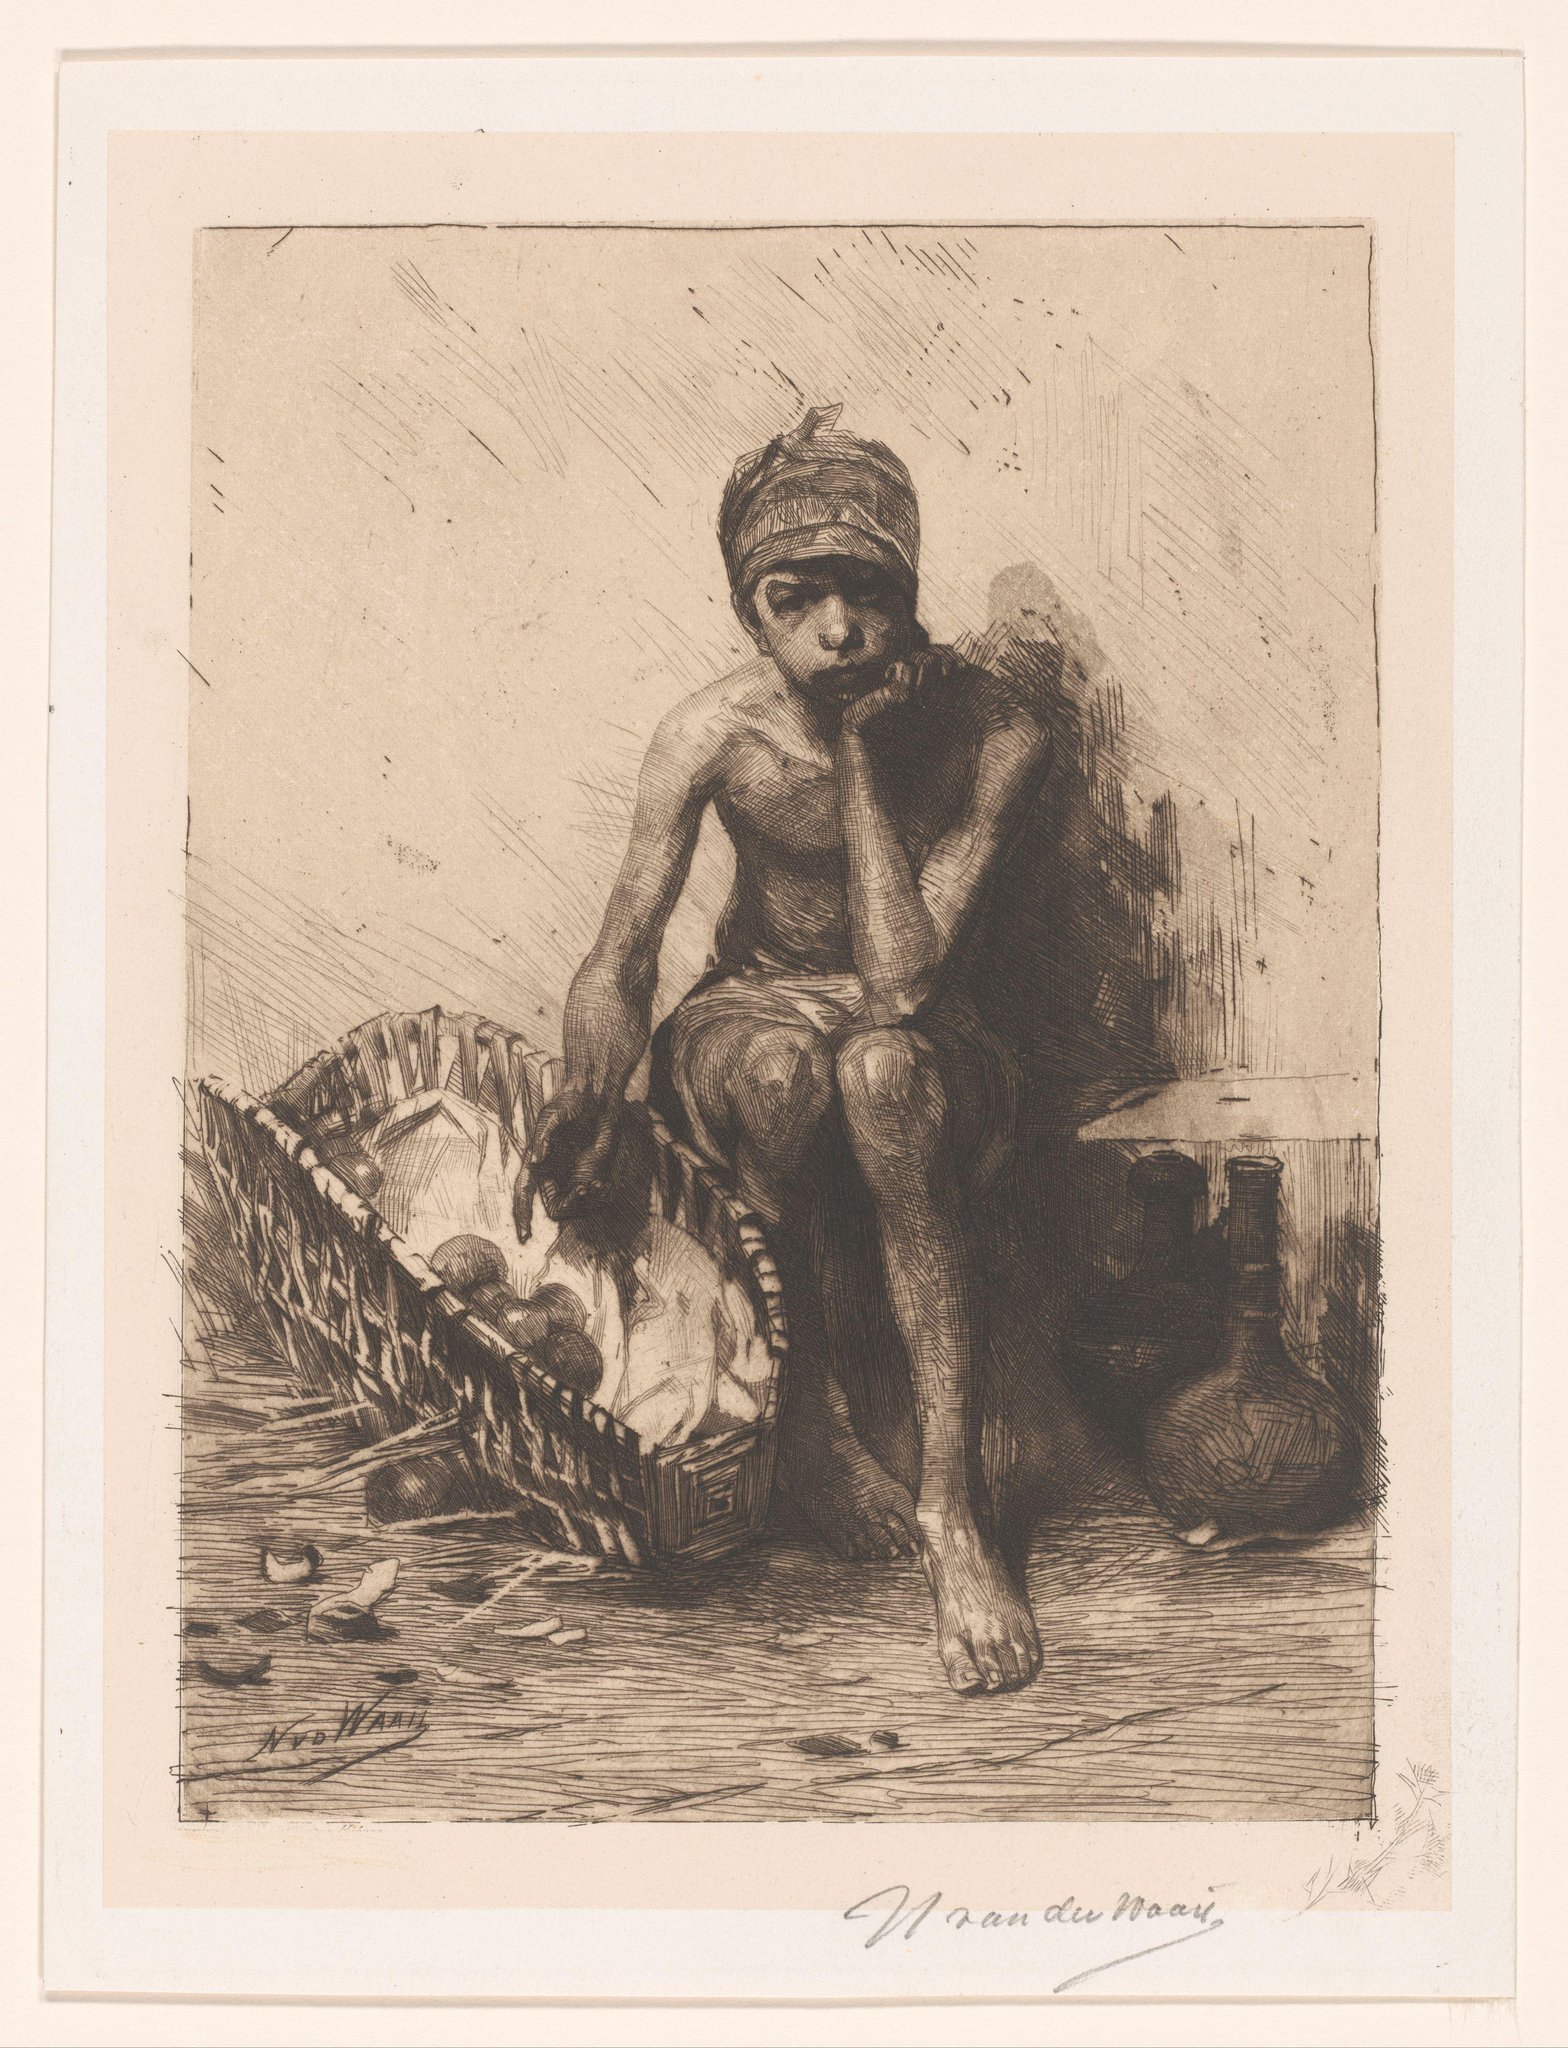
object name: print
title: Vruchtenverkoper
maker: nicolaas van der waay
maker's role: draughtsman, painter, print maker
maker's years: 1855-1936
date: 1865-1936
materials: paper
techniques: aquatint, etching, intaglio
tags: fruits, merchant, salesman, naples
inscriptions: collector's mark: Lugt 2228